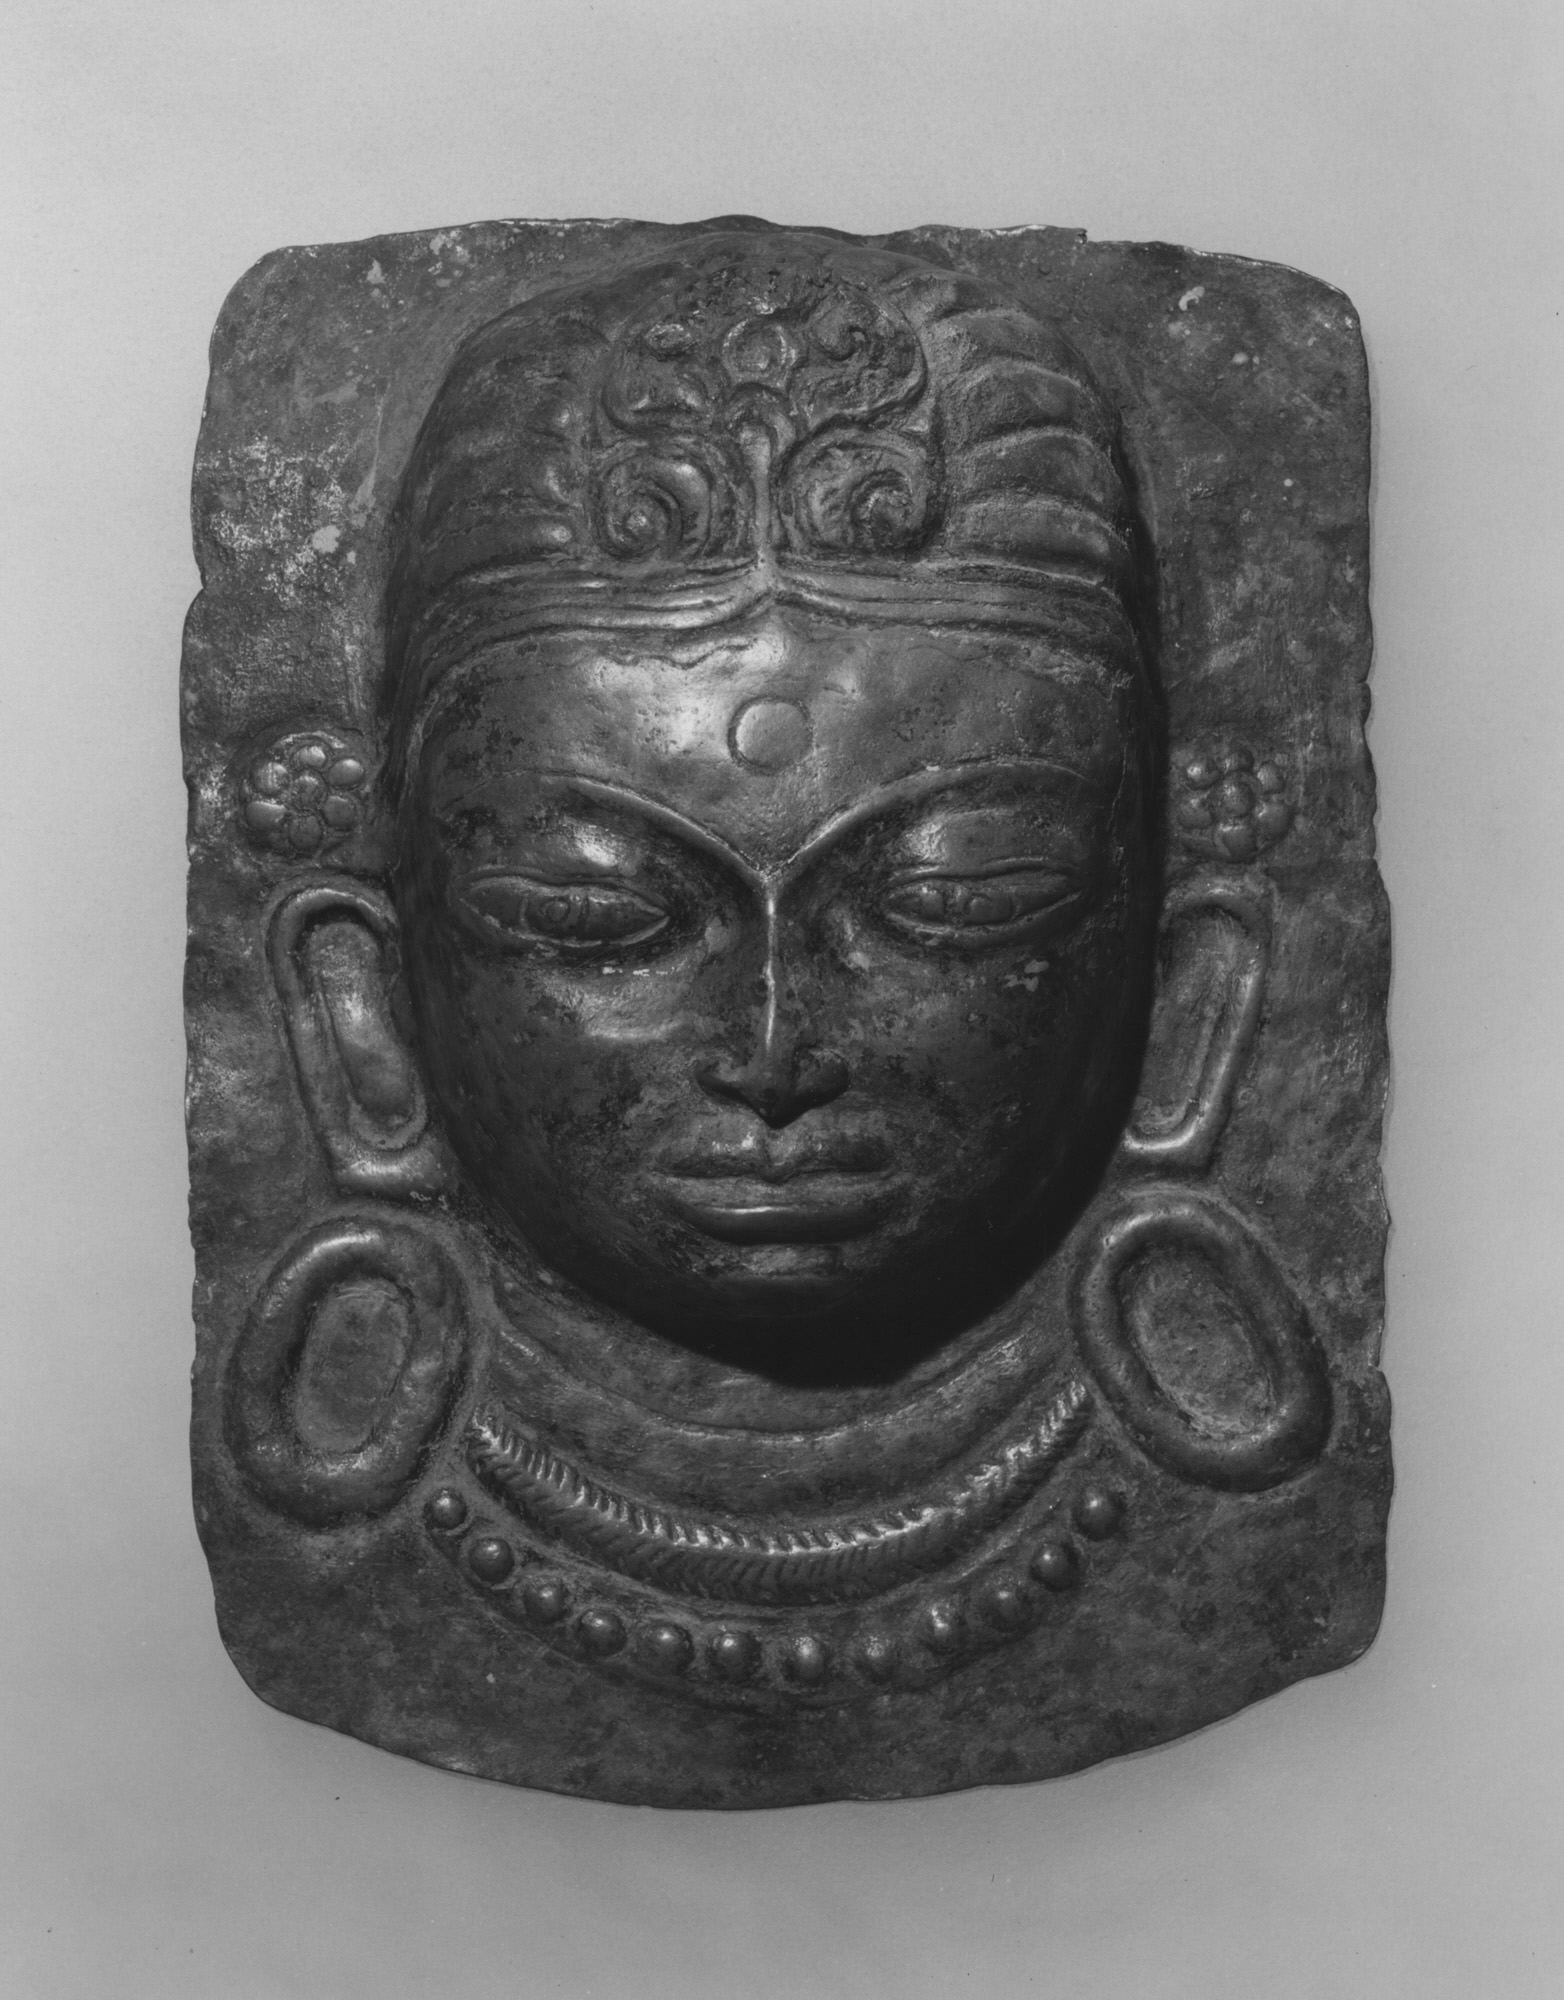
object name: relief plaque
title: Mask of a Deity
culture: nepali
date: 1301-1600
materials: copper alloy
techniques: repoussé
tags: masks